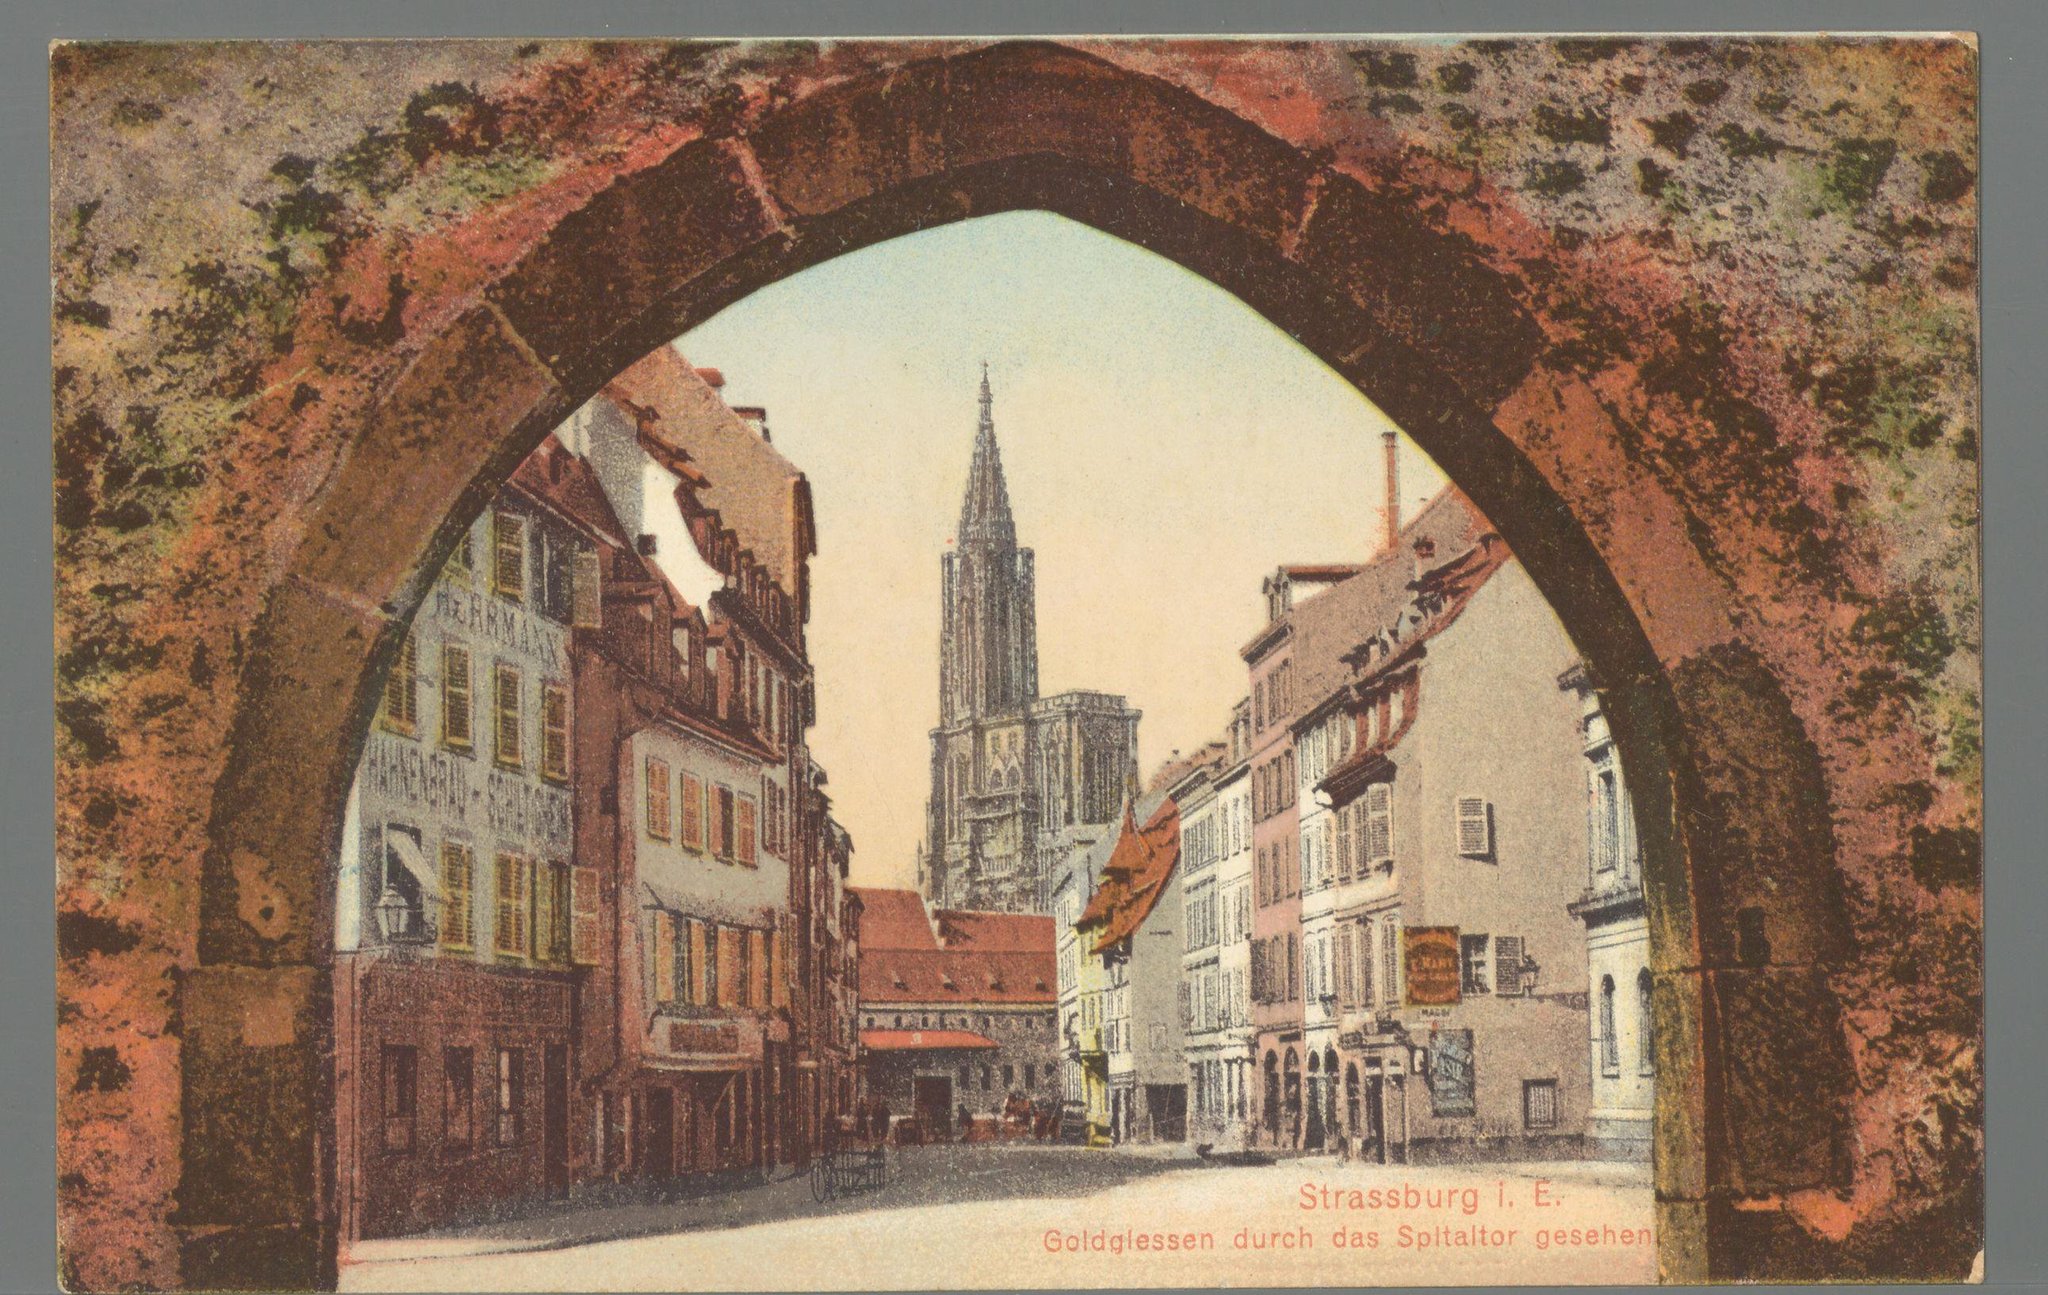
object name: ansichtkaart, prentbriefkaart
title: Strassburg i. E. Goldglessen durch das Spitaltor gesehen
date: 1905-1930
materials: cardboard, photographic process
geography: straatsburg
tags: church (exterior), city-gate